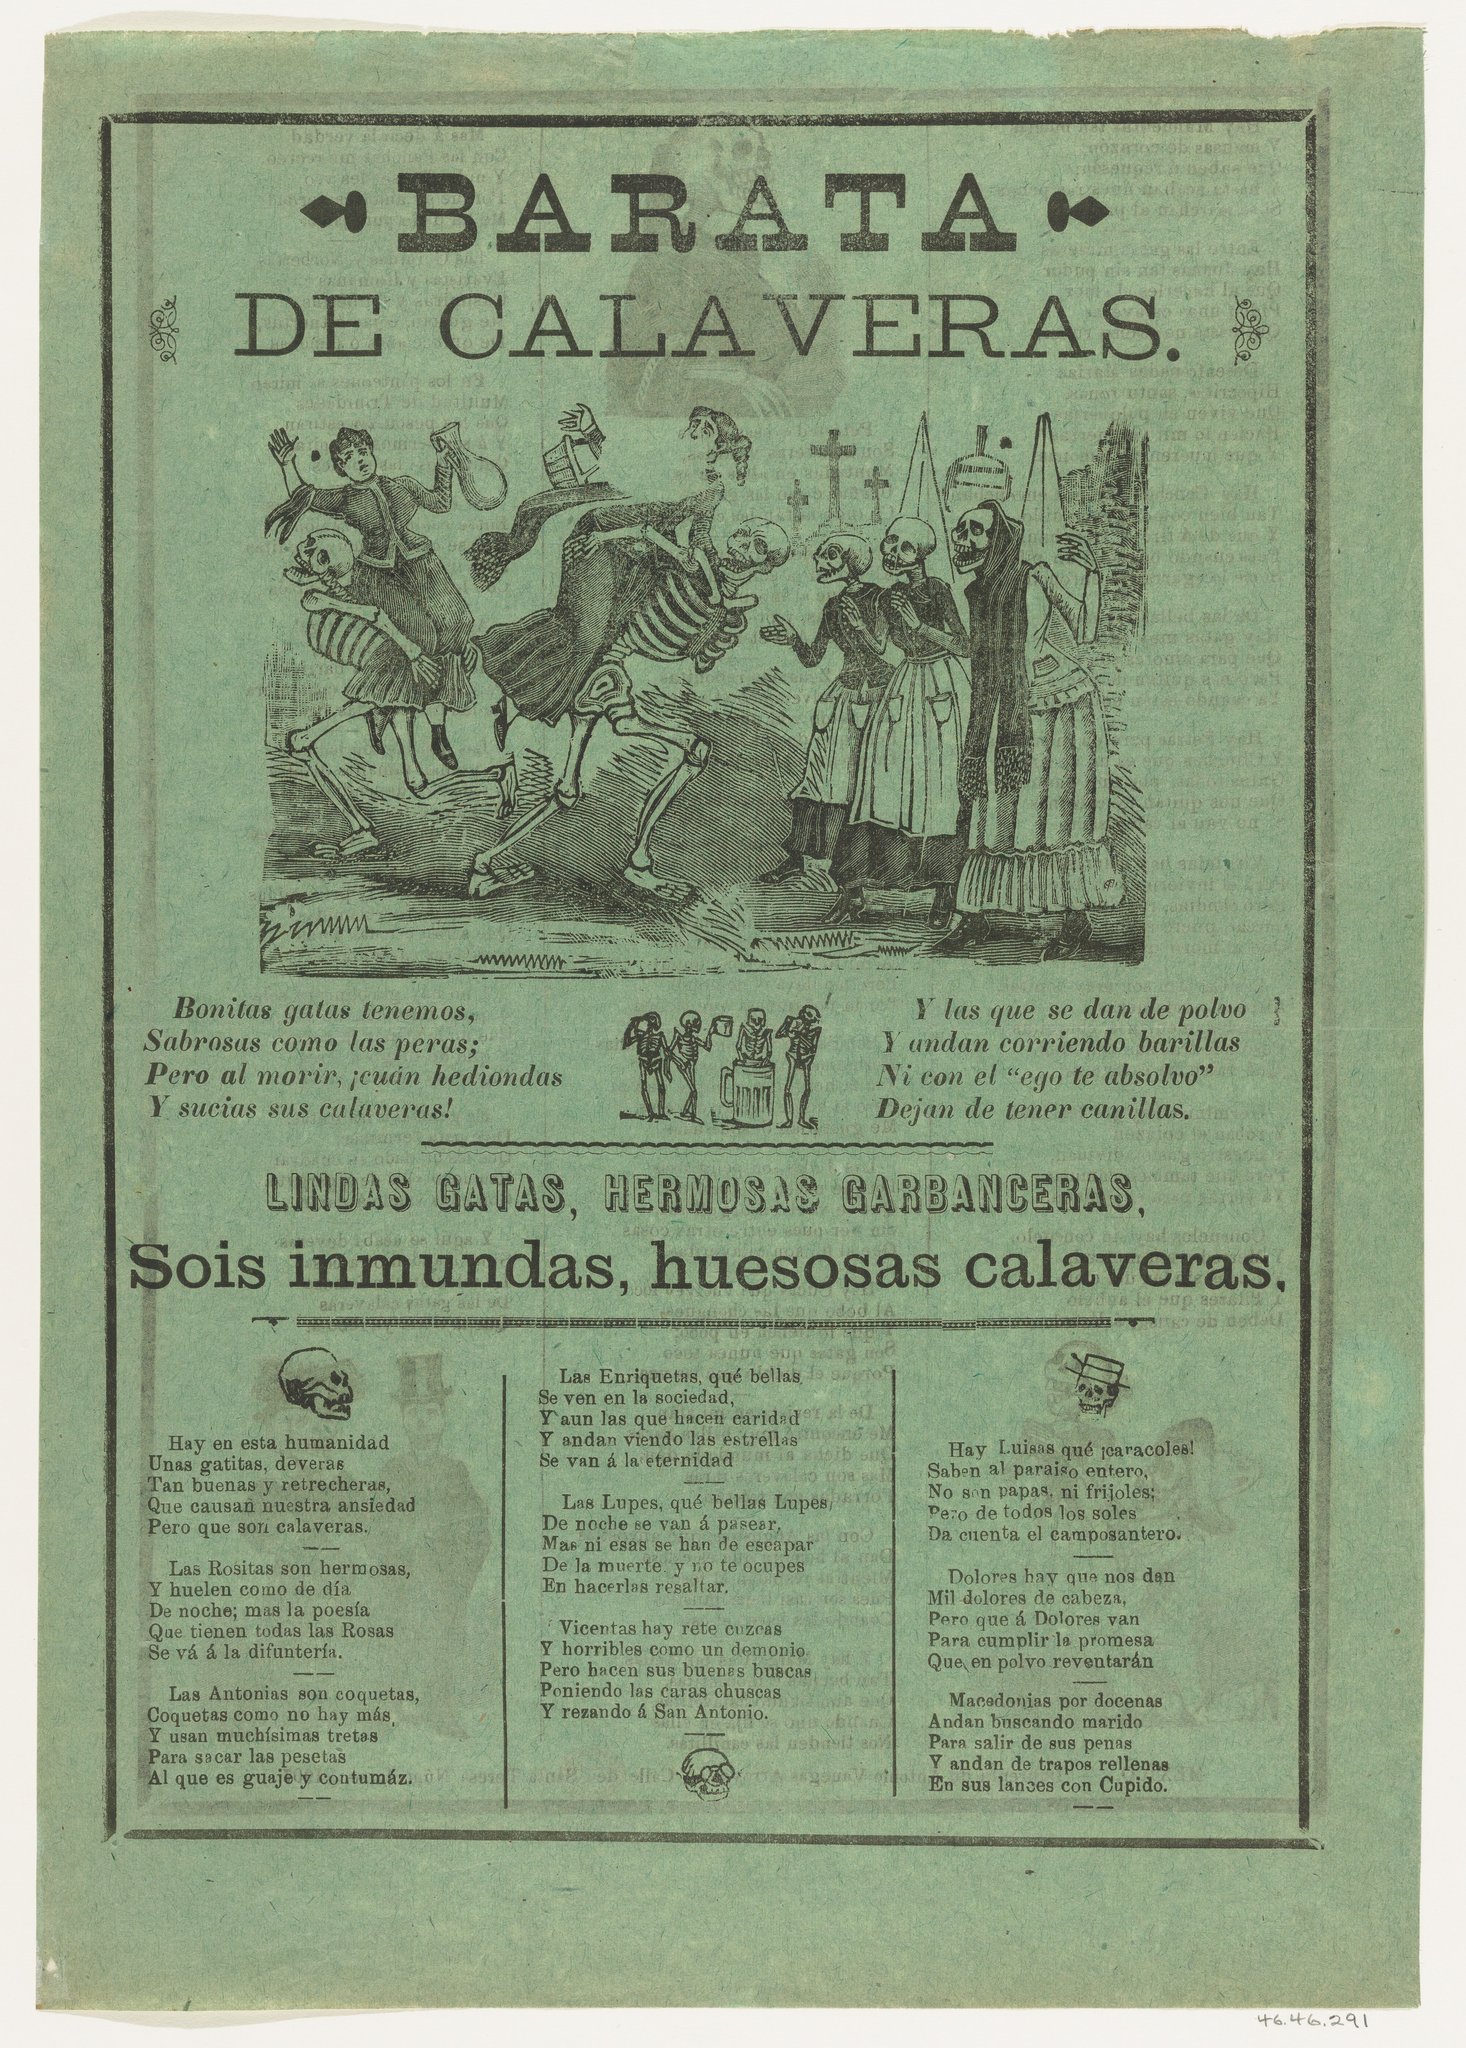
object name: print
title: The sale of skeletons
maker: josé guadalupe posada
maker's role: artist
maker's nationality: mexican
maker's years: 1852-1913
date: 1907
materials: metal, paper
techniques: engraving, letterpress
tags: skeletons